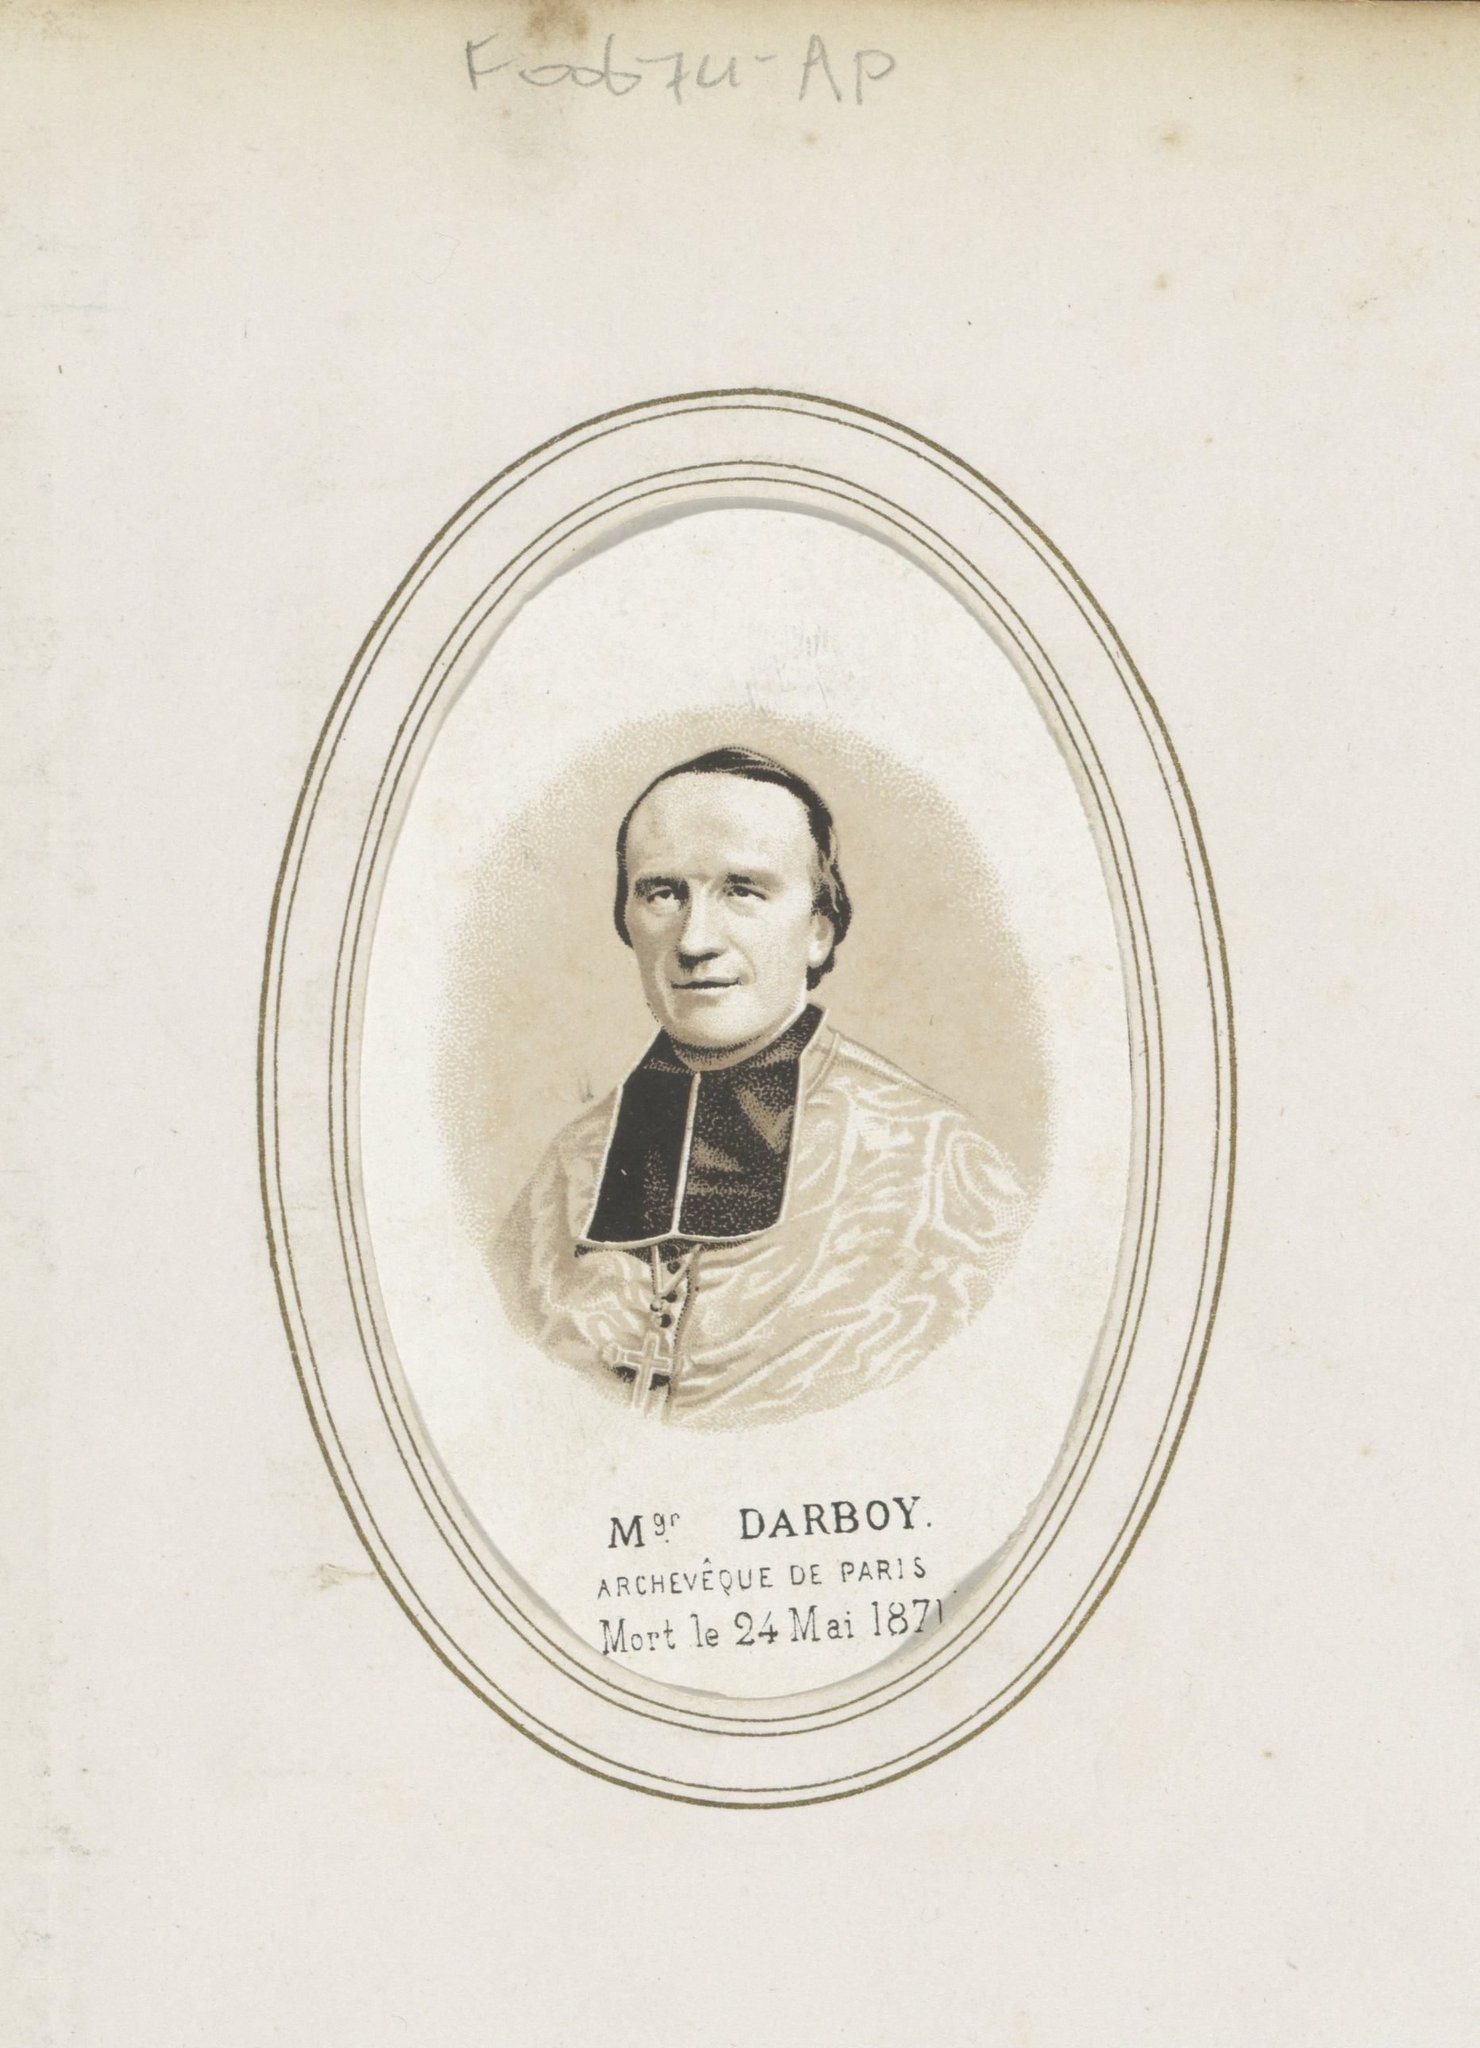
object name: print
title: Mgr. Darboy Archevêque de Paris Mort le 24 Mai 1871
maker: Anonymous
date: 1871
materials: paper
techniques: tone lithography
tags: paris, archbishop, bishop, etc. (roman catholic), chasuble, neck-gear: jabot, historical persons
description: Onderdeel van Fotoalbum met 123 cartes-de-visite van leden van Europese vorstenhuizen, politici en bekende personen.